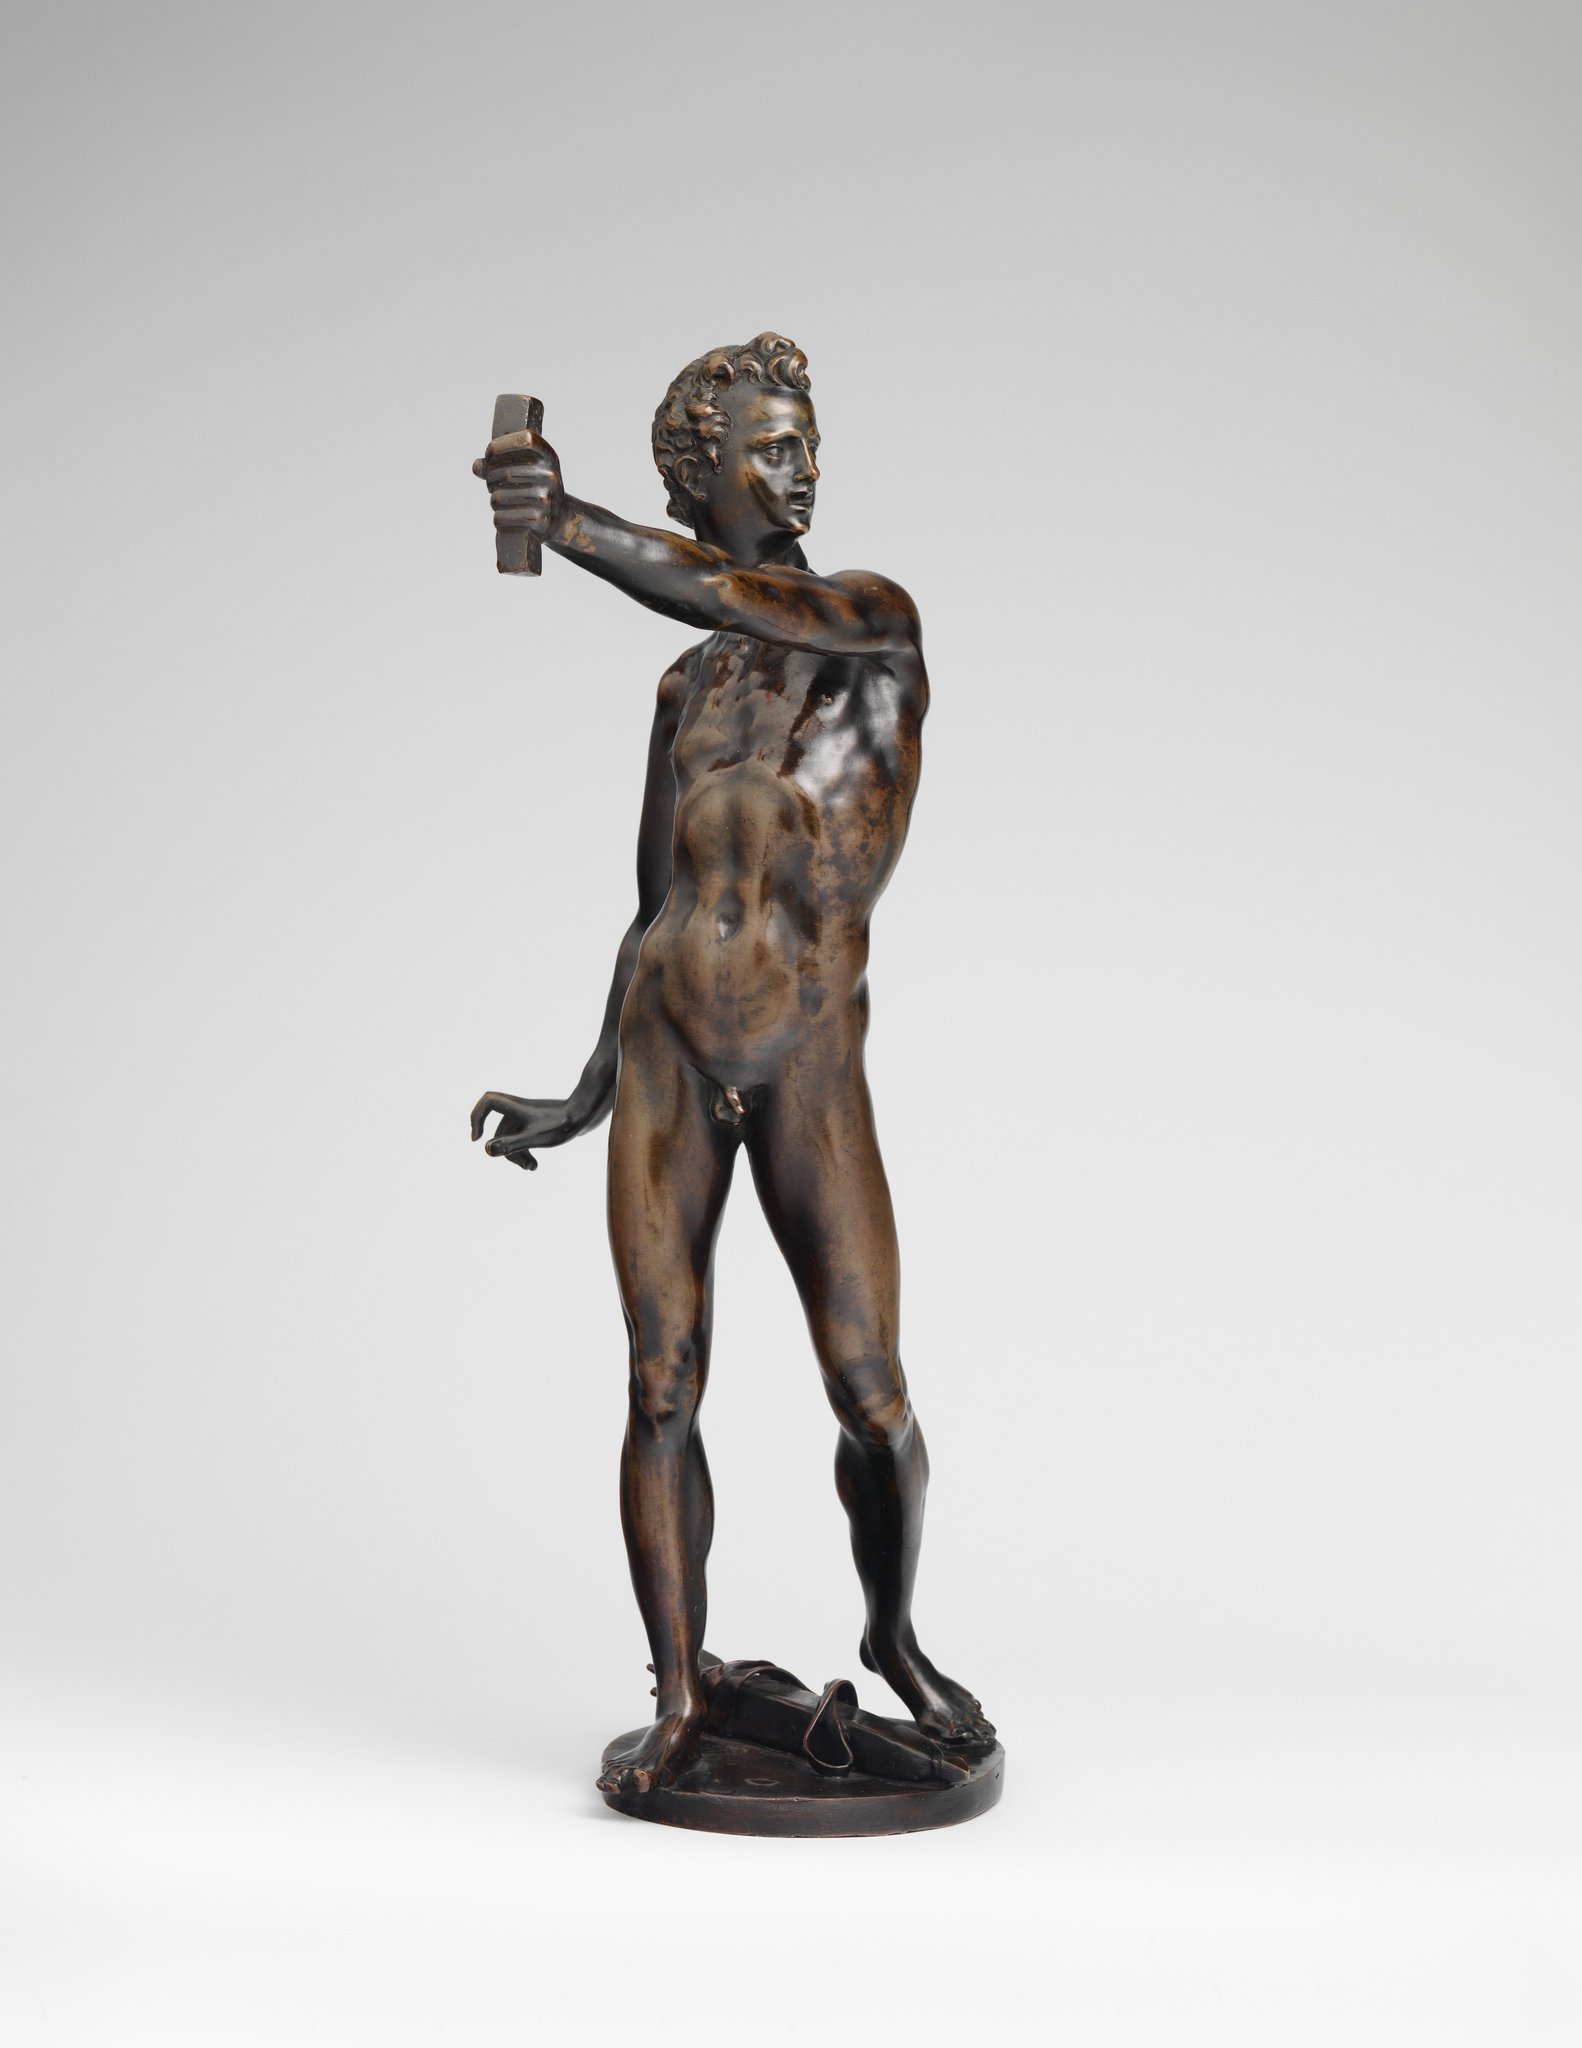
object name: statuette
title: Apollo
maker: adriaen de vries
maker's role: artist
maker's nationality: netherlandish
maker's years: 1545-1626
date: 1594-1598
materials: bronze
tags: male nudes,apollo